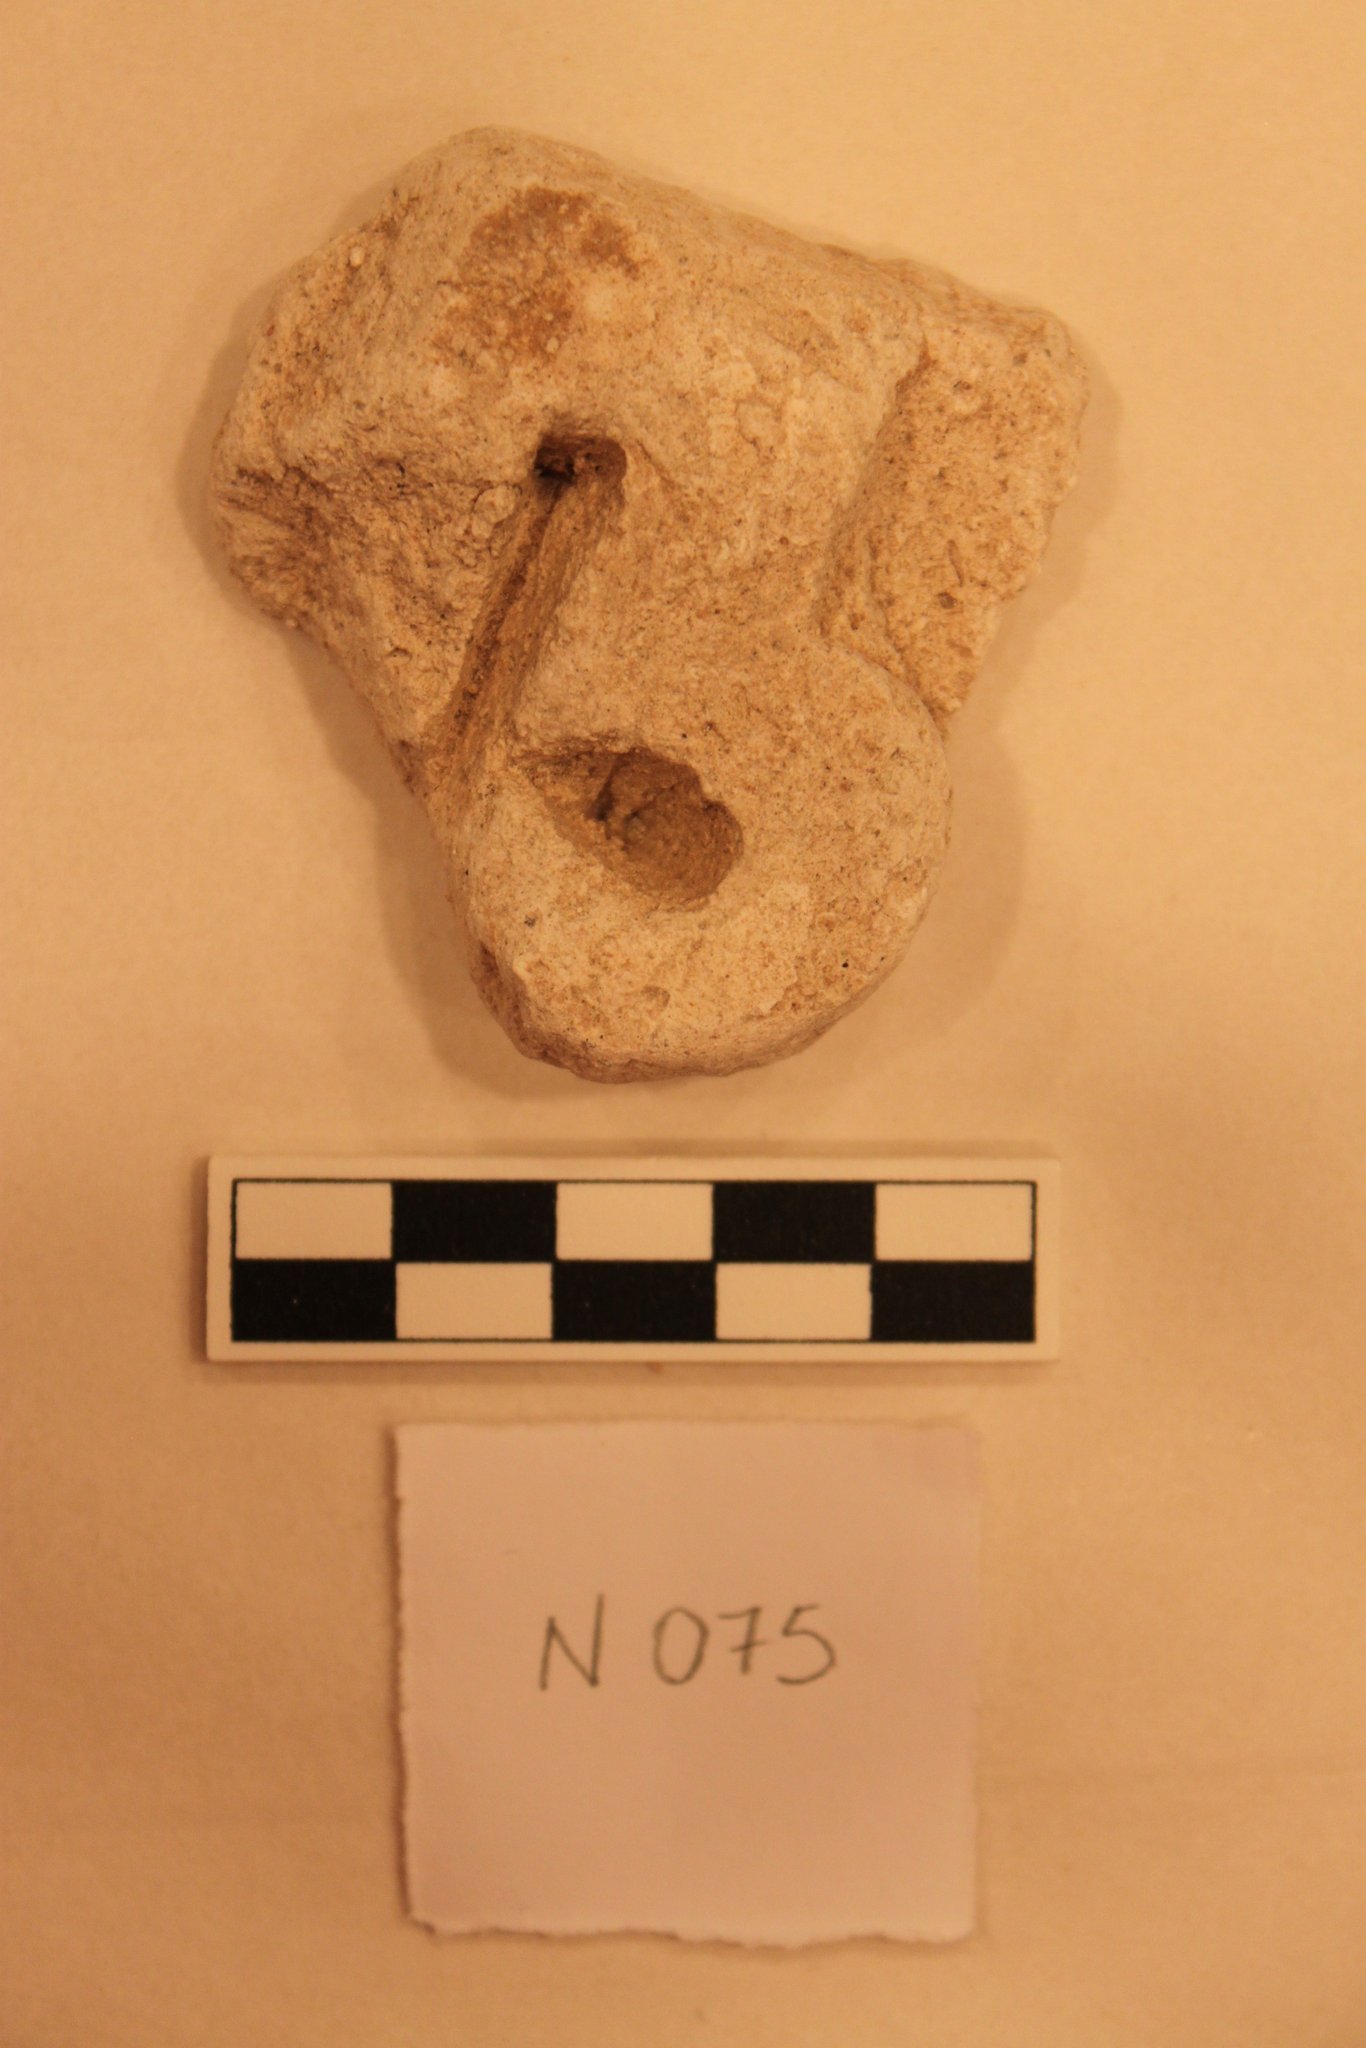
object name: fragment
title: Stucco Fragment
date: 701-1200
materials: plaster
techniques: carving, painting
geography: iran